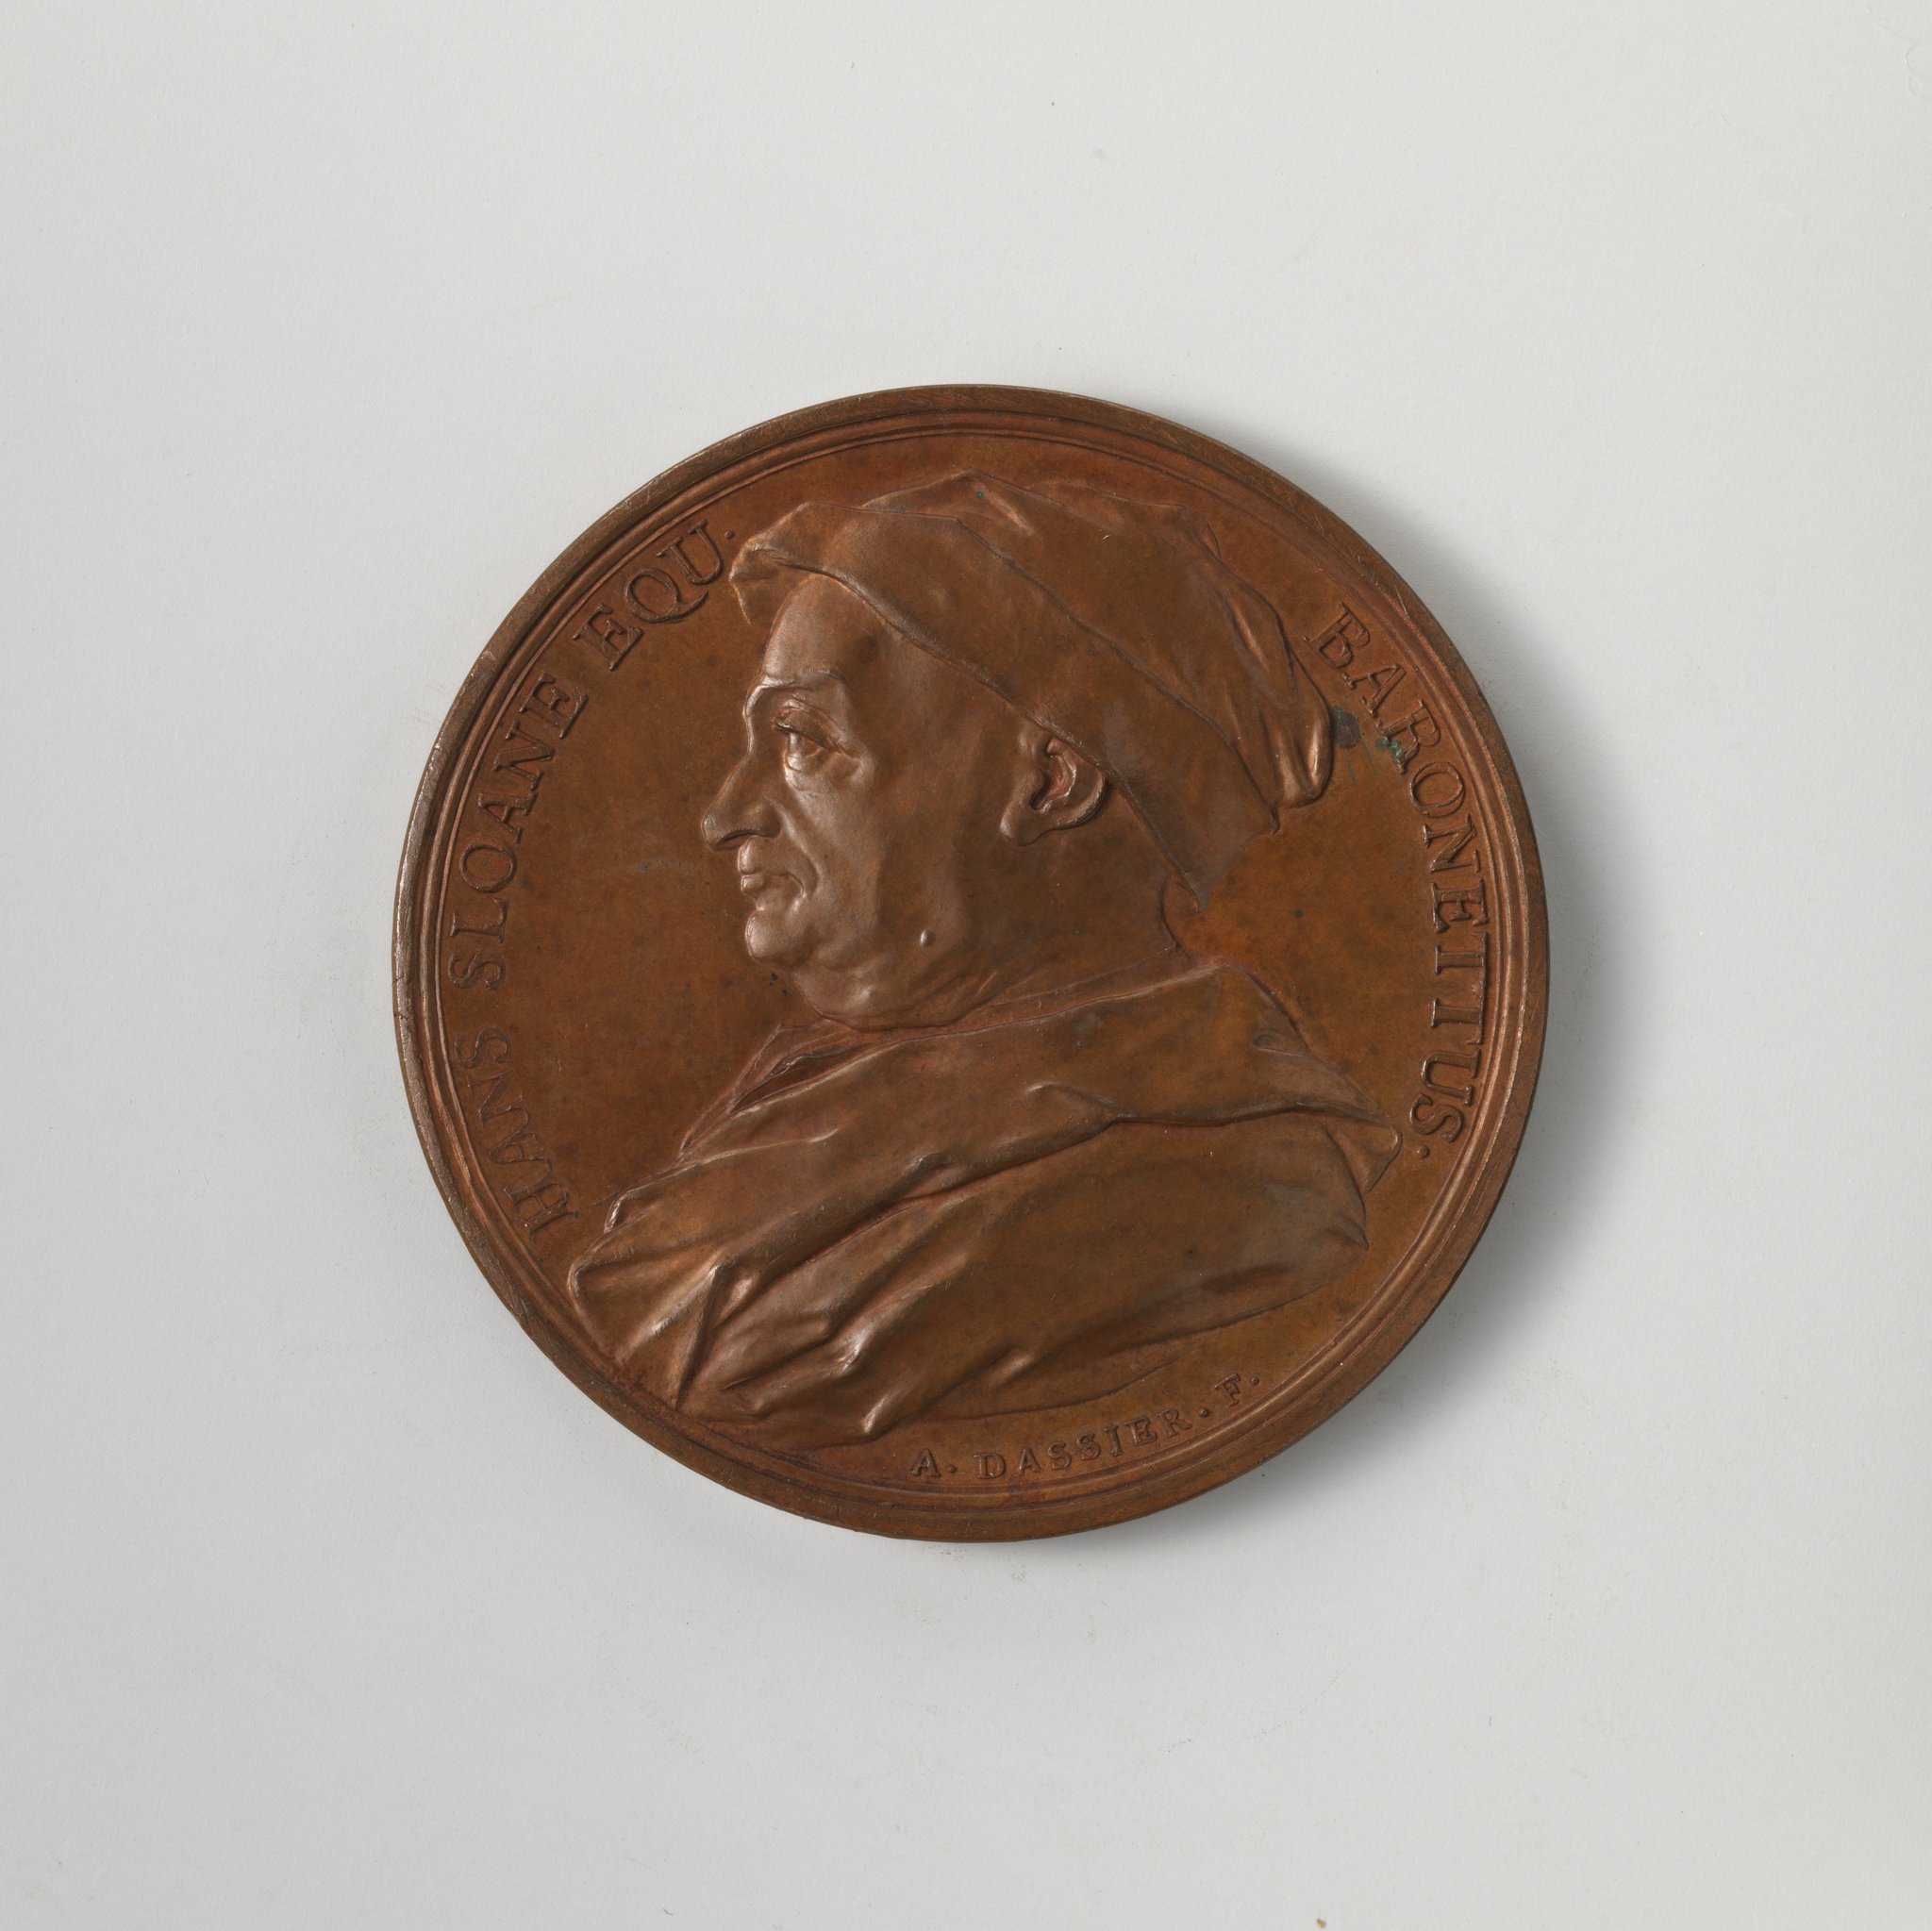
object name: medal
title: Sir Hans Sloane, 1st Baronet (1660–1753)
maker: jacques-antoine dassier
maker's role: artist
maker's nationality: swiss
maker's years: 1715-1759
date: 1744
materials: bronze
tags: men,profiles